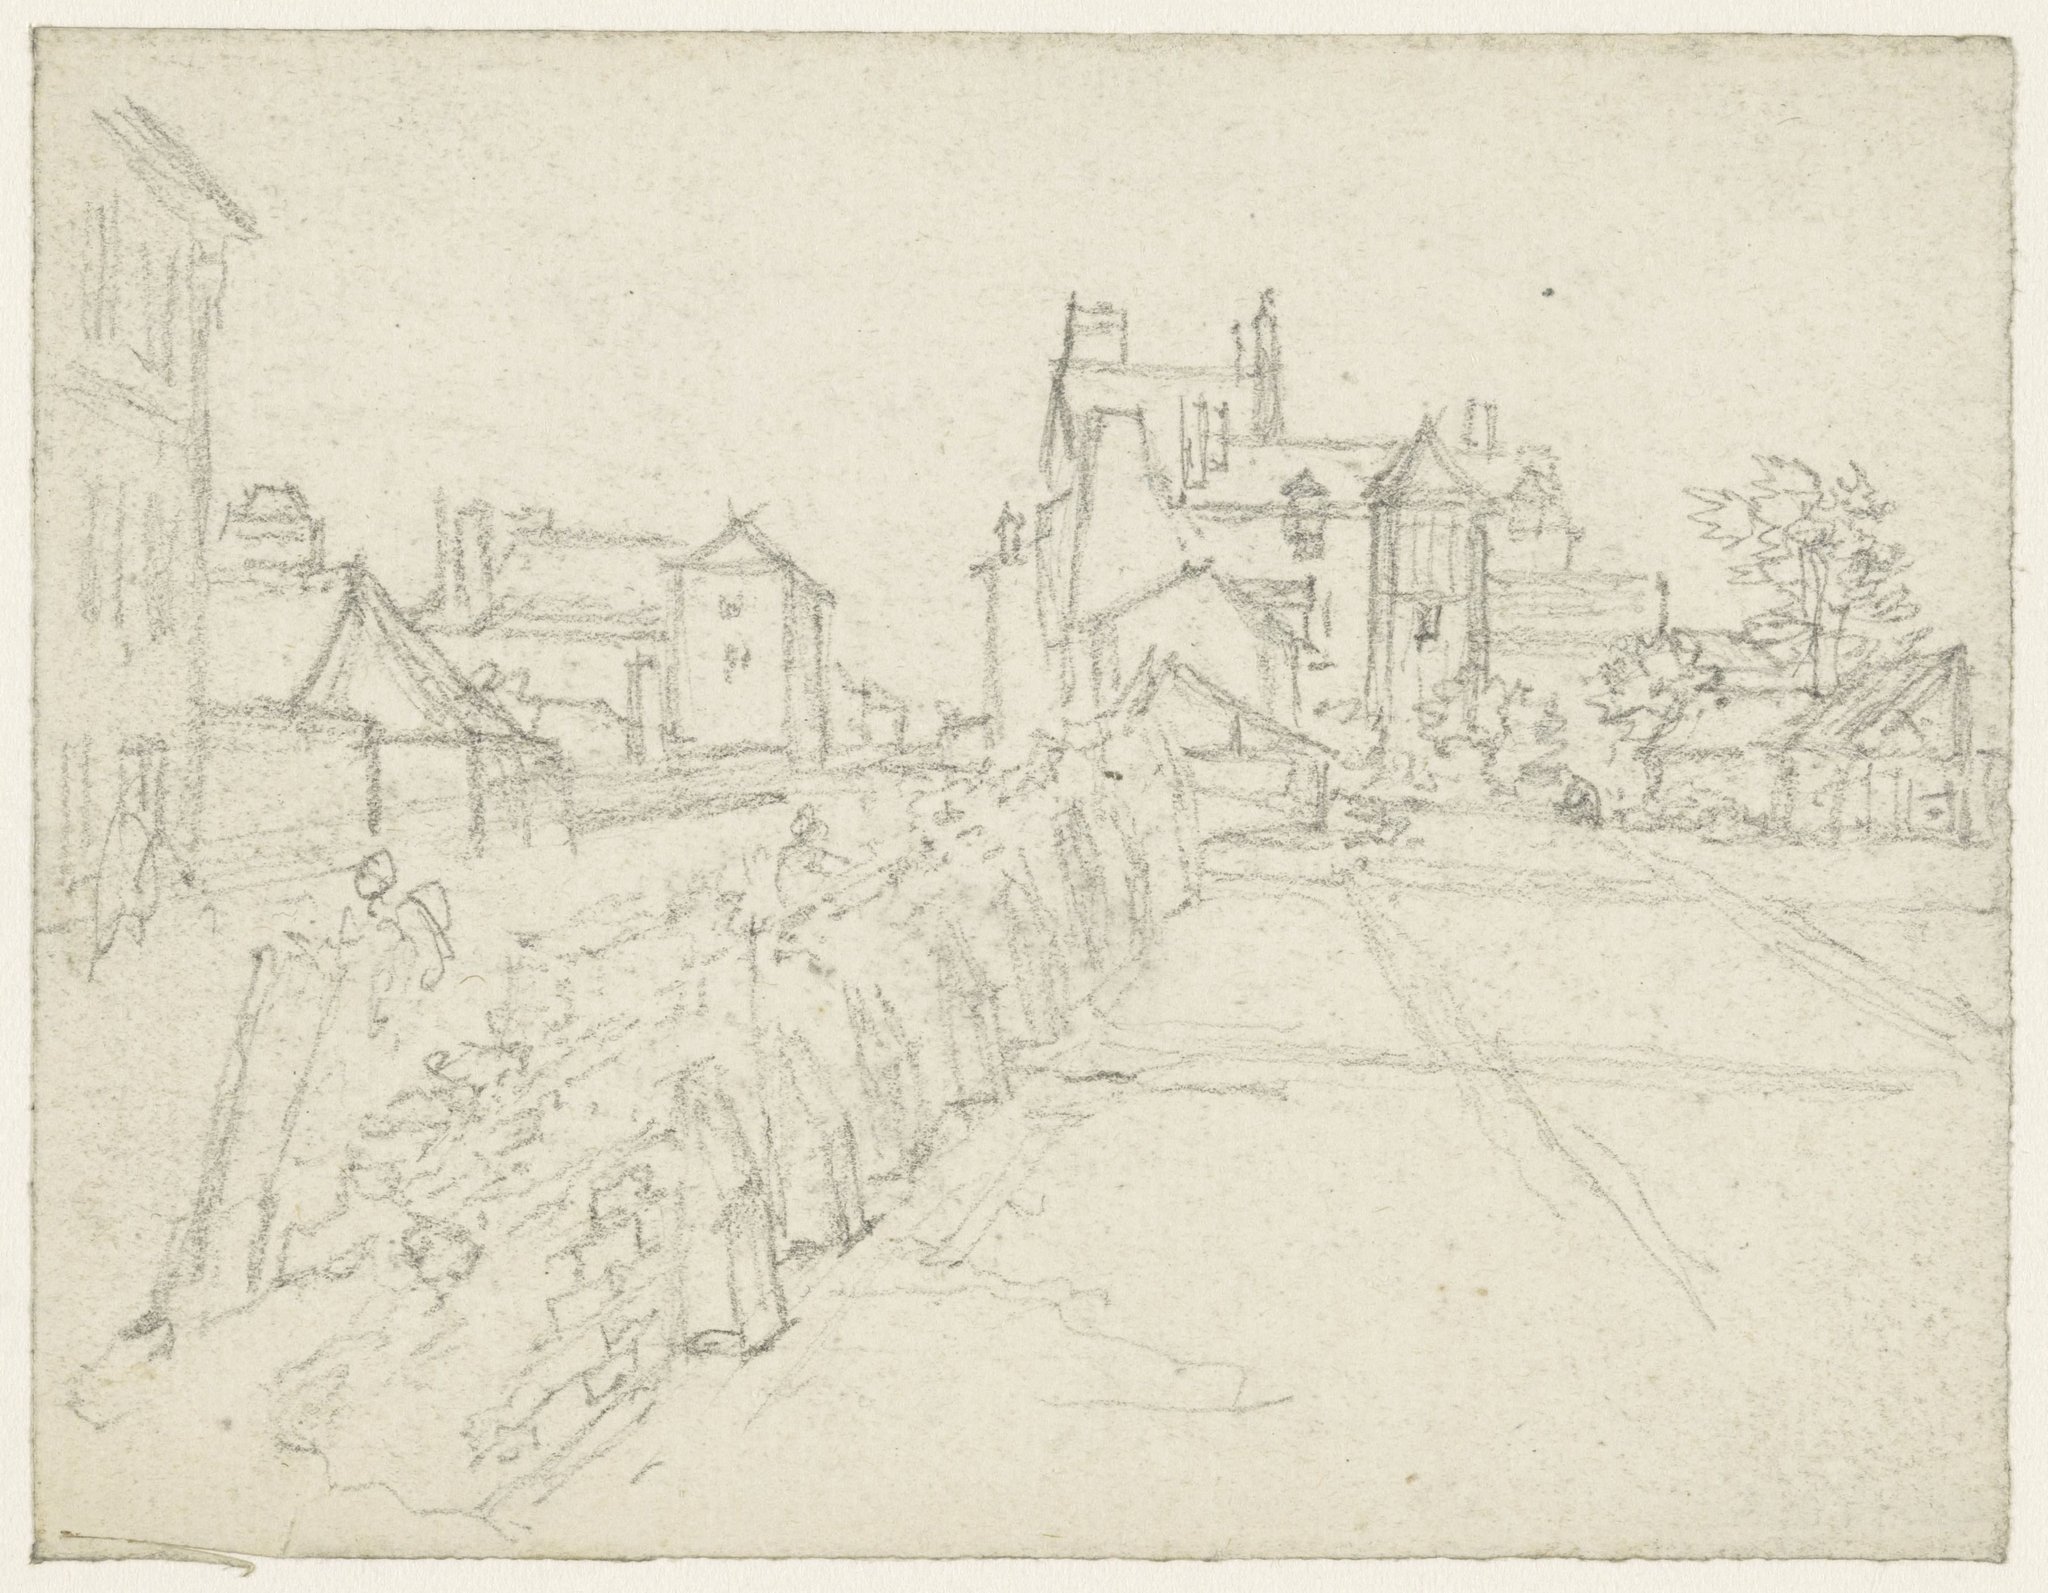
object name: drawing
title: Straat waarin een muur afgebroken wordt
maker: georges michel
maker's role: draughtsman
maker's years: 1763-1843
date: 1773-1843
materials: paper, pencil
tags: outskirts of city, public road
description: Een van 120 tekeningen, afkomstig uit een 19e eeuws album met tekeningen van Georges Michel.